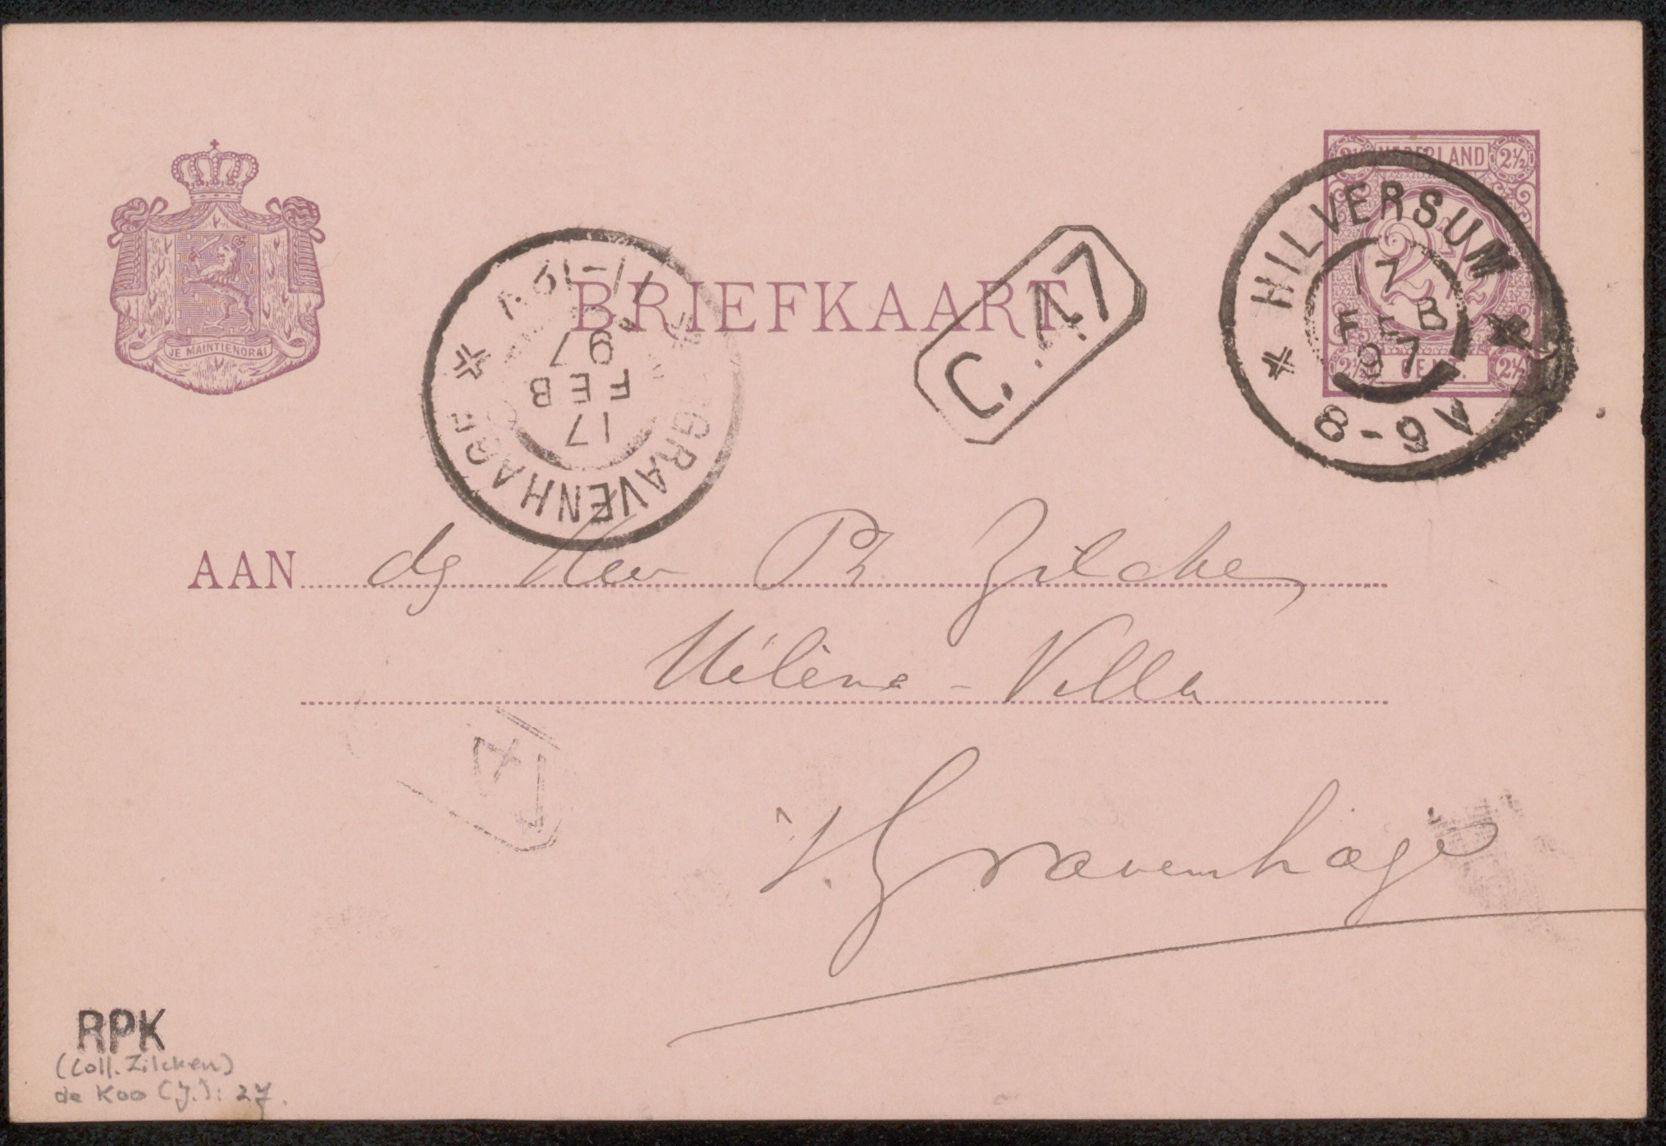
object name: postcard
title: Briefkaart aan Philip Zilcken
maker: johannes de koo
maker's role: auteur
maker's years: 1841-1909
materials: cardboard, ink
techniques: pen, writing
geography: hilversum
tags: rembrandt van rijn, amsterdam, abraham bredius, the hague, painter, philip zilcken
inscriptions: collector's mark: ‘RPK’